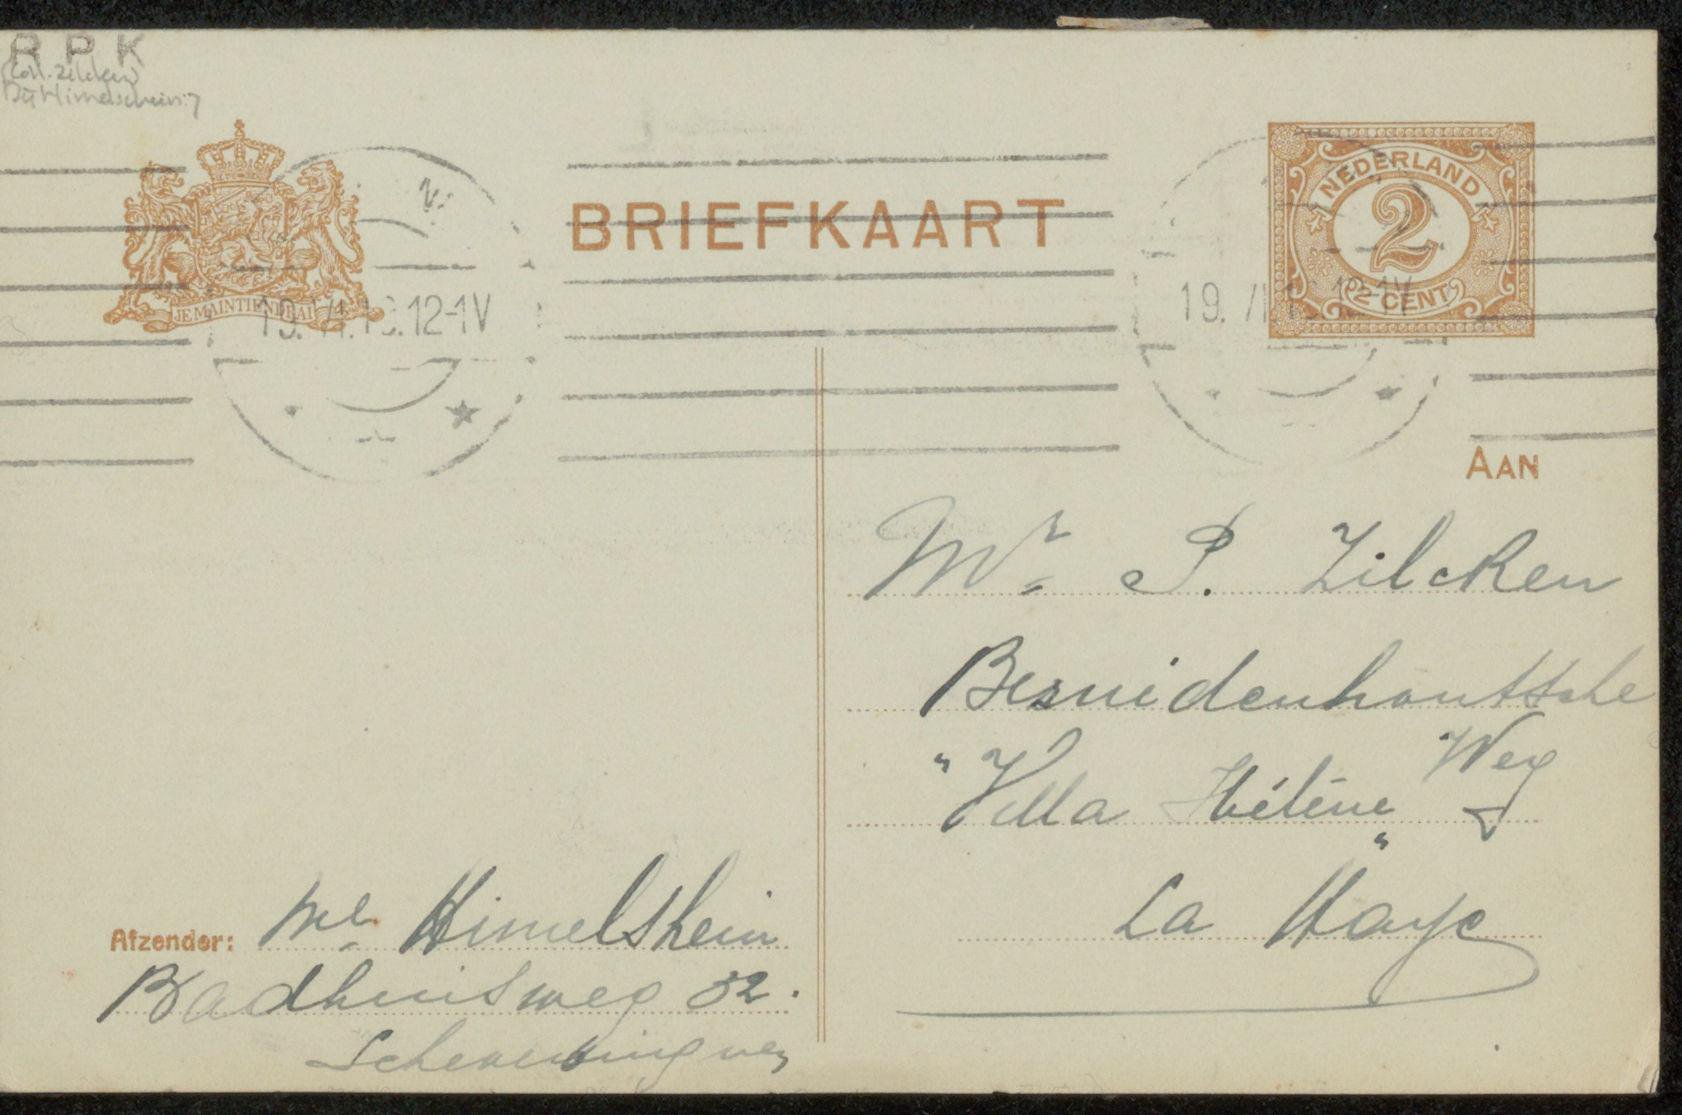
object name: postcard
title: Briefkaart aan Philip Zilcken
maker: mevrouw r. himelschein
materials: cardboard, ink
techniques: pen, writing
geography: scheveningen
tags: rose imel, painter, draughtsman, philip zilcken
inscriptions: collector's mark: ‘RPK’